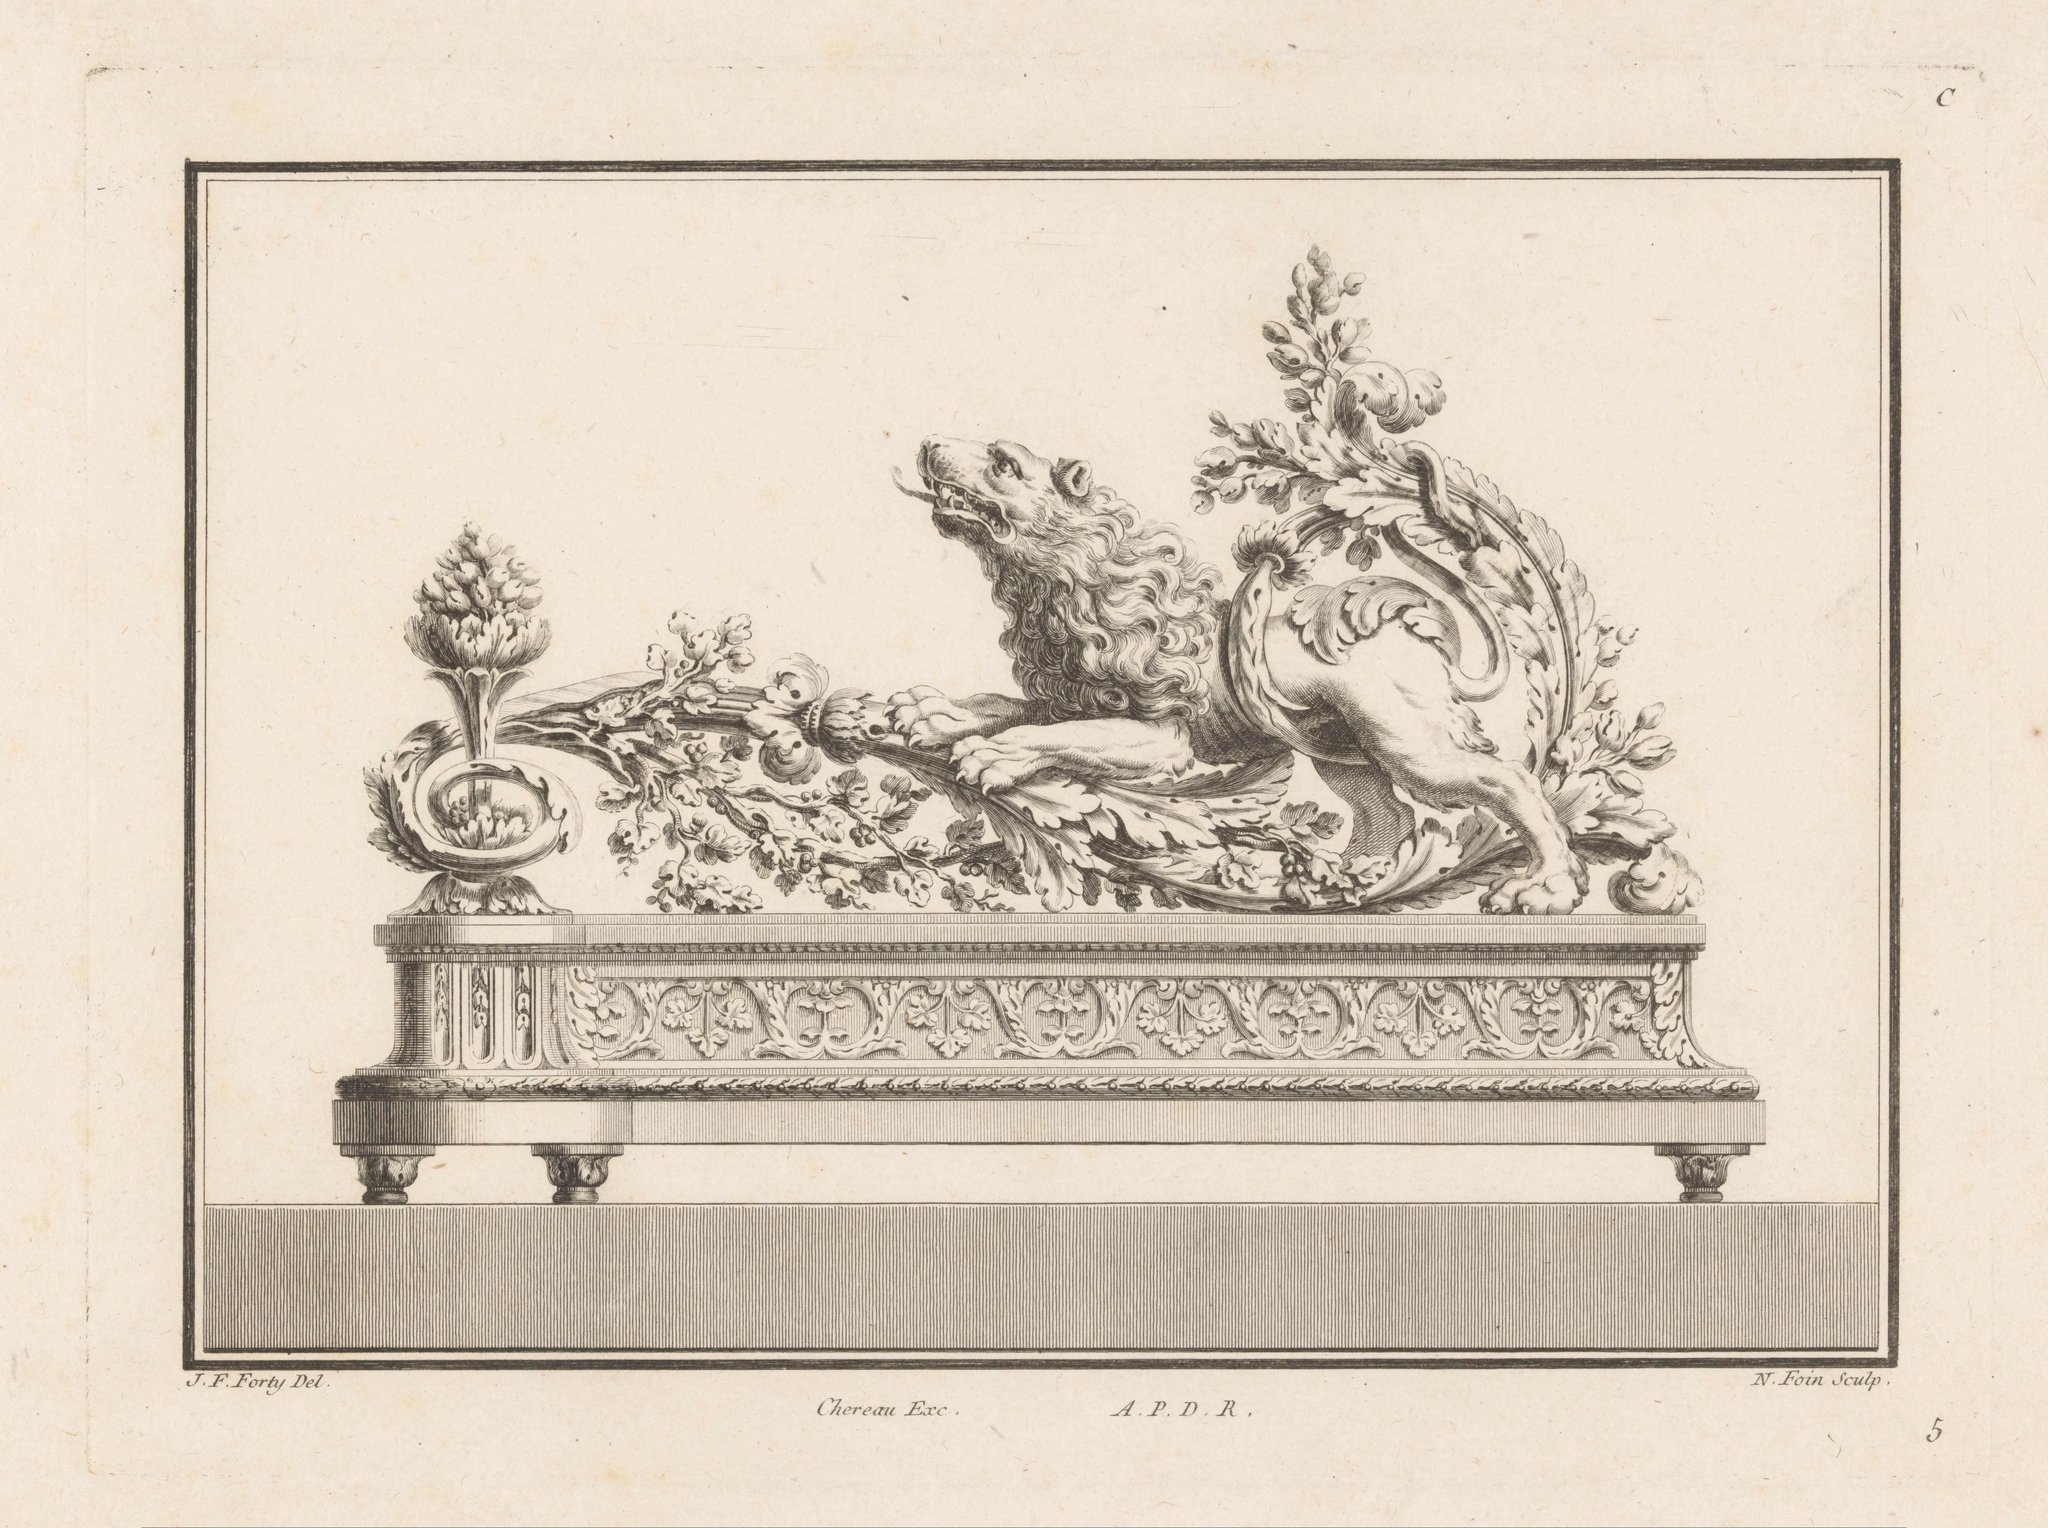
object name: print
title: Oeuvres de Sculptures en Bronze, Contenant Girandoles, Flambeaux, Feux (...)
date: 1775-1790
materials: paper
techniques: engraving, etching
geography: paris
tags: andiron, fire-dog, beasts of prey, predatory animals: lion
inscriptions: collector's mark: Lugt 2228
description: Een geornamenteerde vuurbok met ranken en rechts een leeuw.